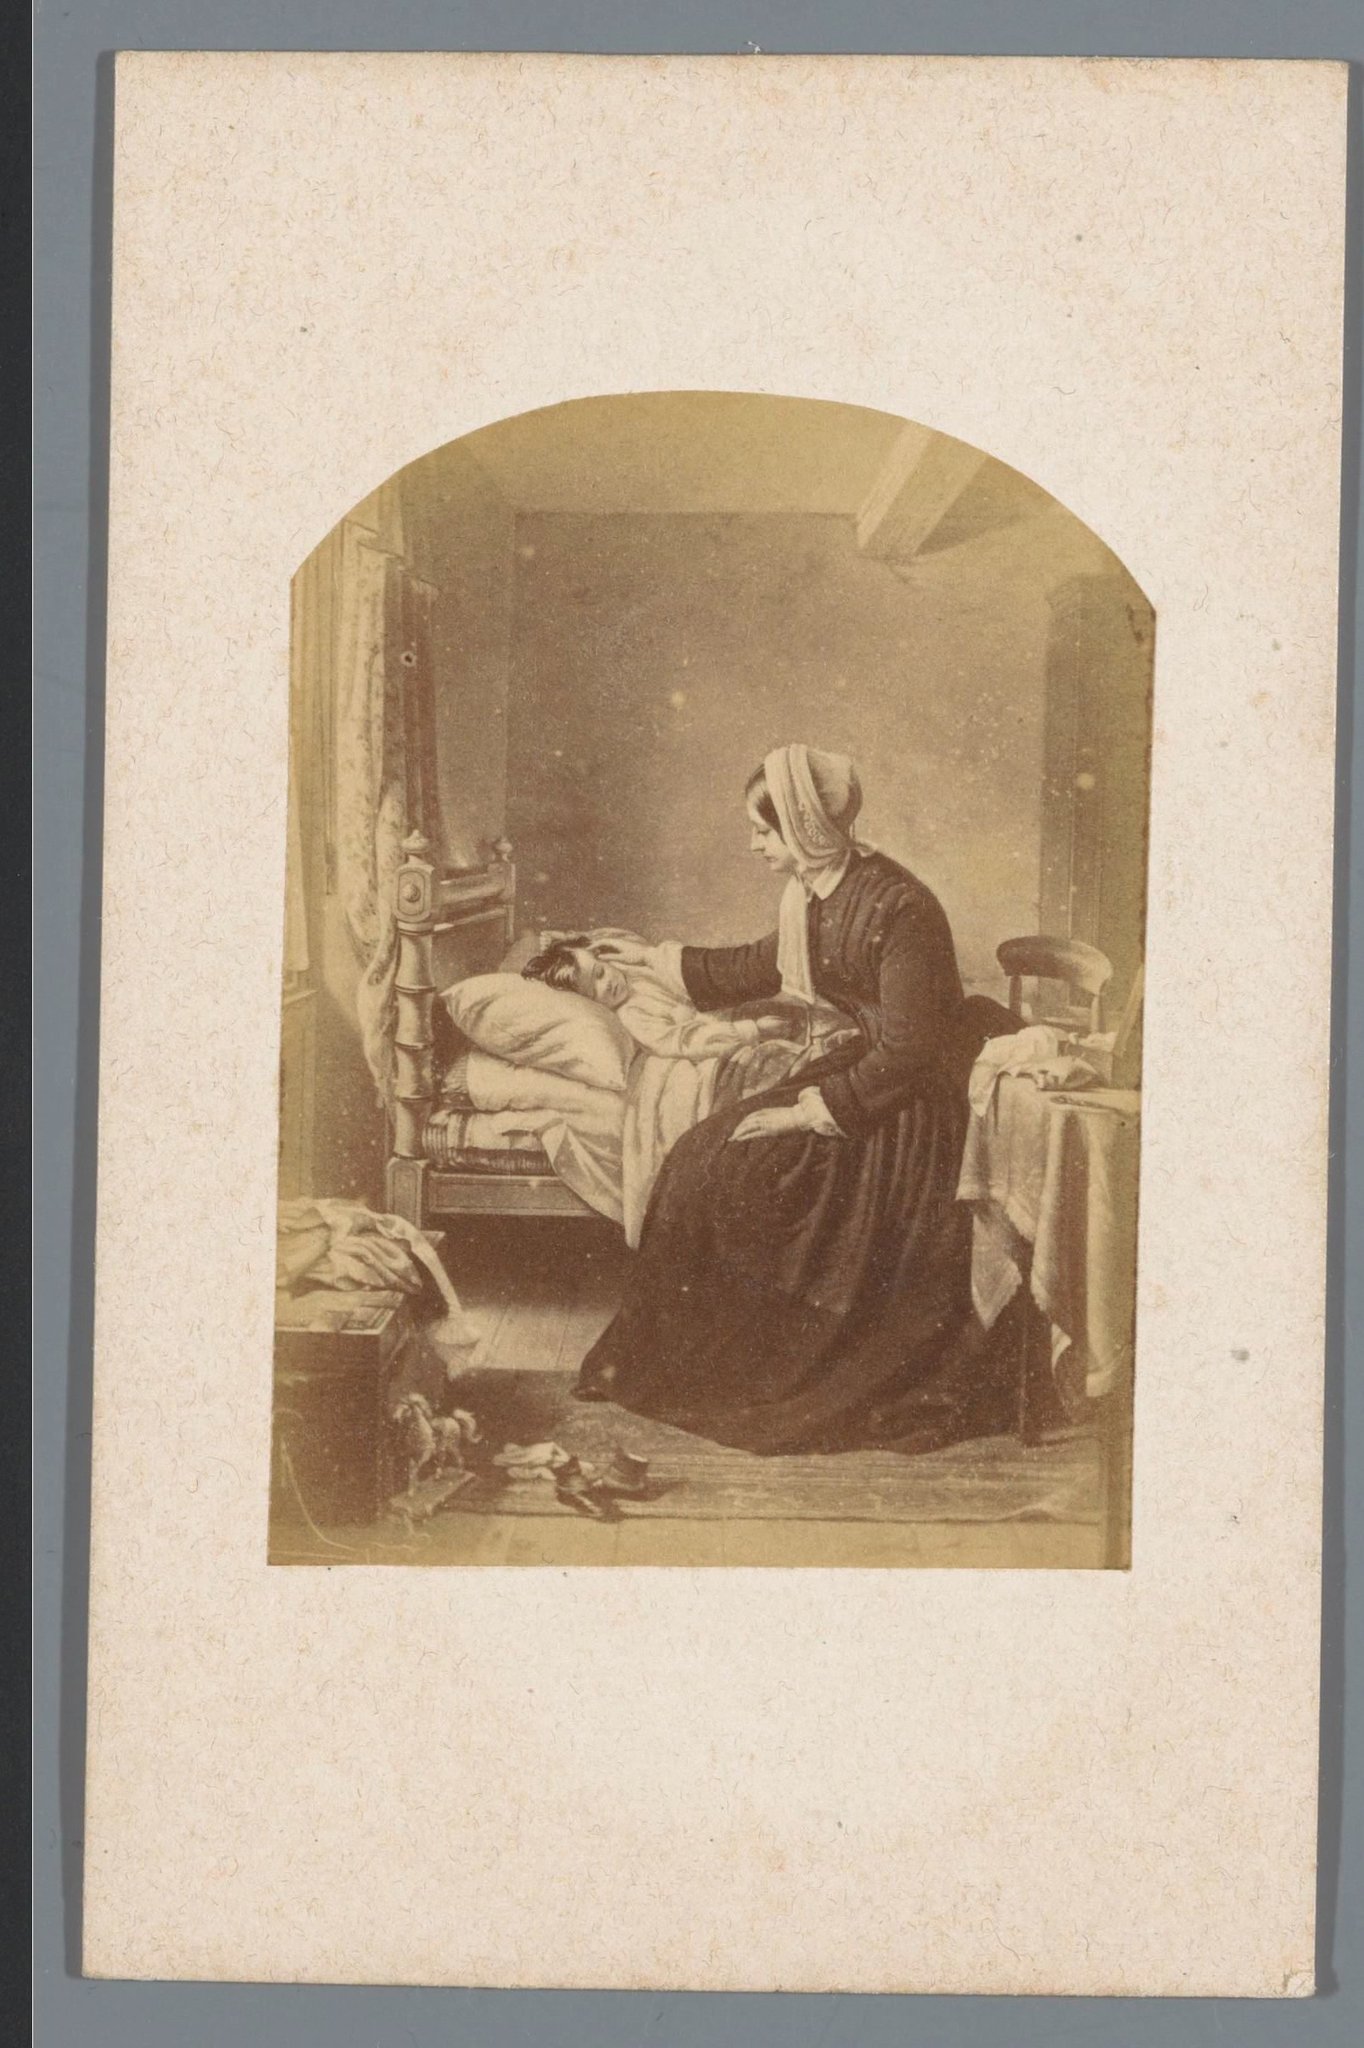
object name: carte de visite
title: Fotoreproductie van een schilderij naar het gedicht In de kinderkamer door J.J.L. ten Kate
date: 1850-1900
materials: cardboard, photographic support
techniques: albumen print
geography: amsterdam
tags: watching a sleeping child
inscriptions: inscription: ‘IN DE KINDERKAMER./ (...) (Vrij naar FRIEDR. MARX.) J. J. L. TEN KATE.’